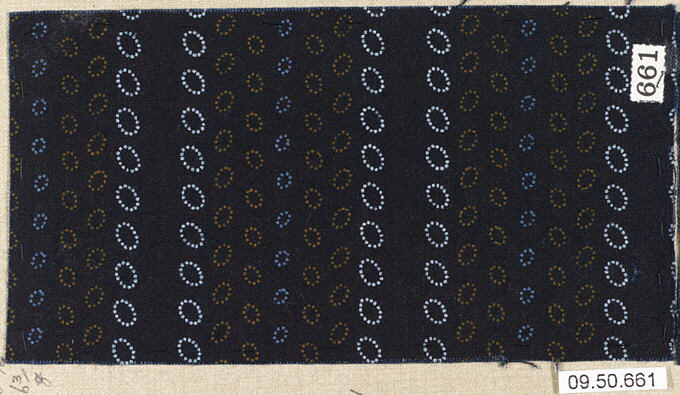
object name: piece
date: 1801-1900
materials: cotton